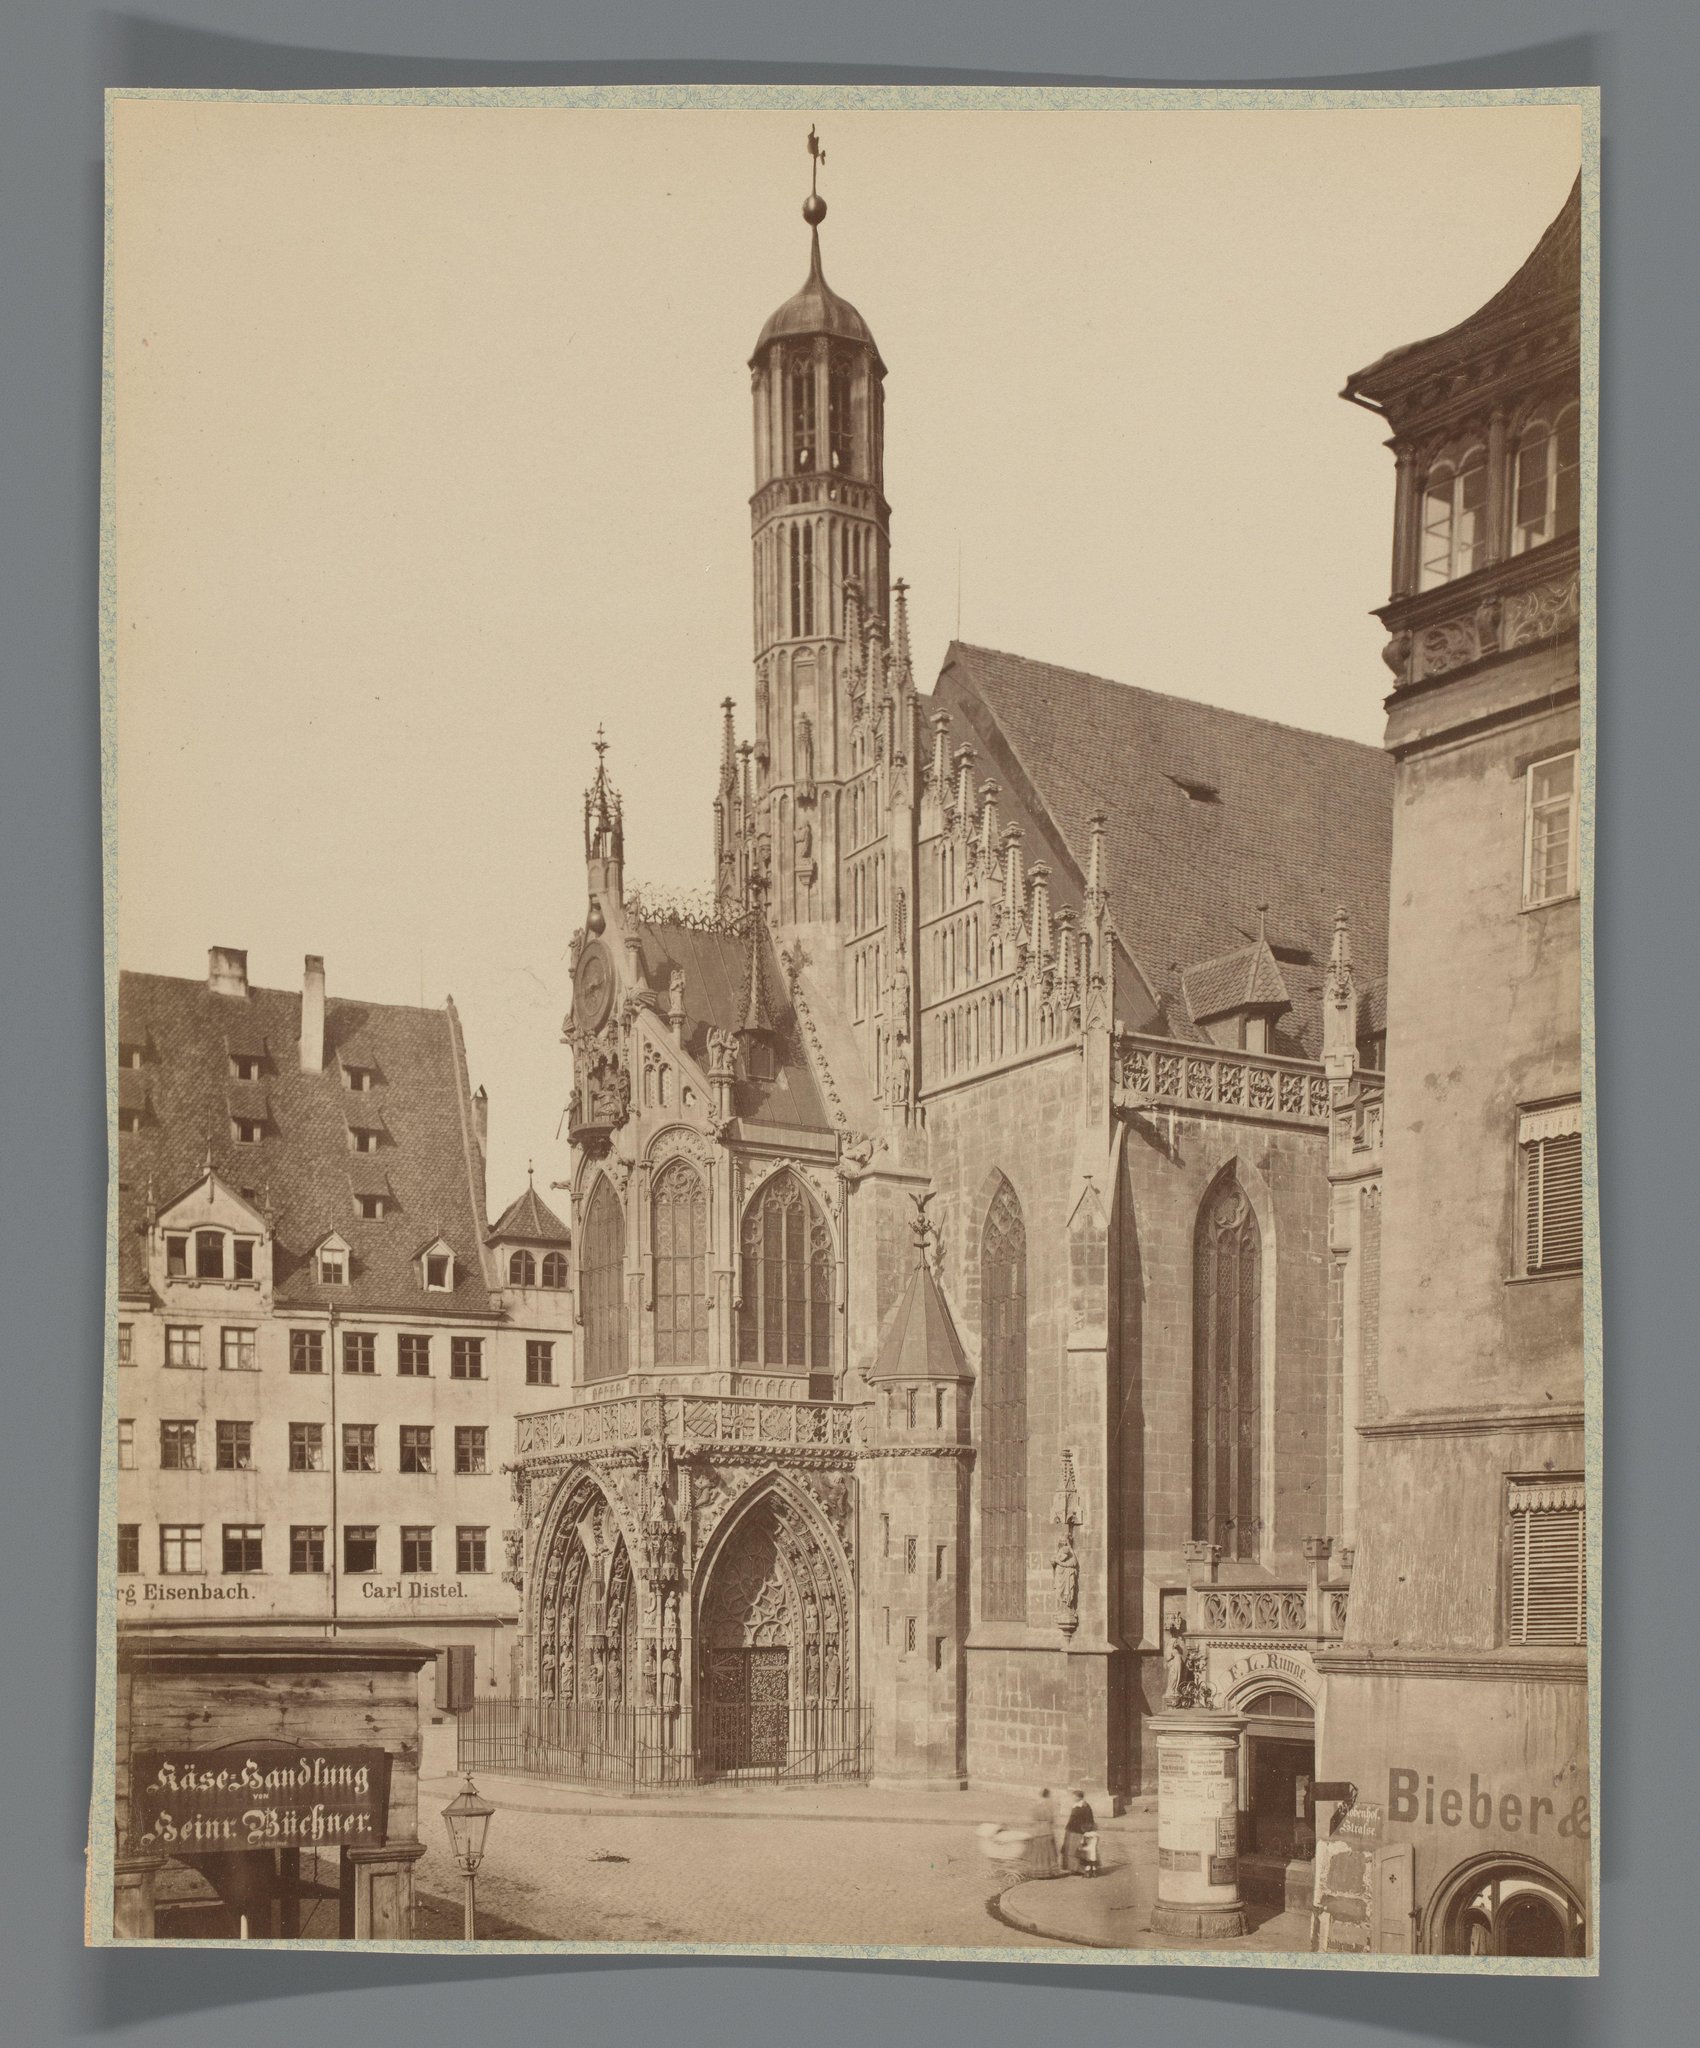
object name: photograph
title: Frauenkirche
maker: Anonymous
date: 1850-1900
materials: photographic support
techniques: albumen print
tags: germany